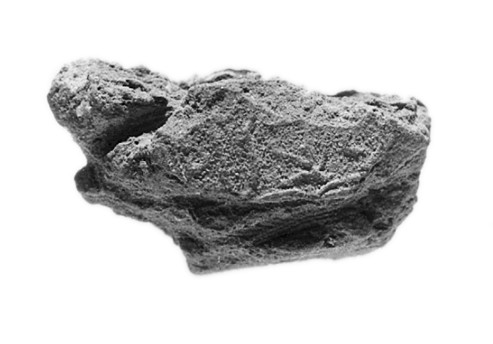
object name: sealing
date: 1981-1640 BCE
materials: mud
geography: egypt